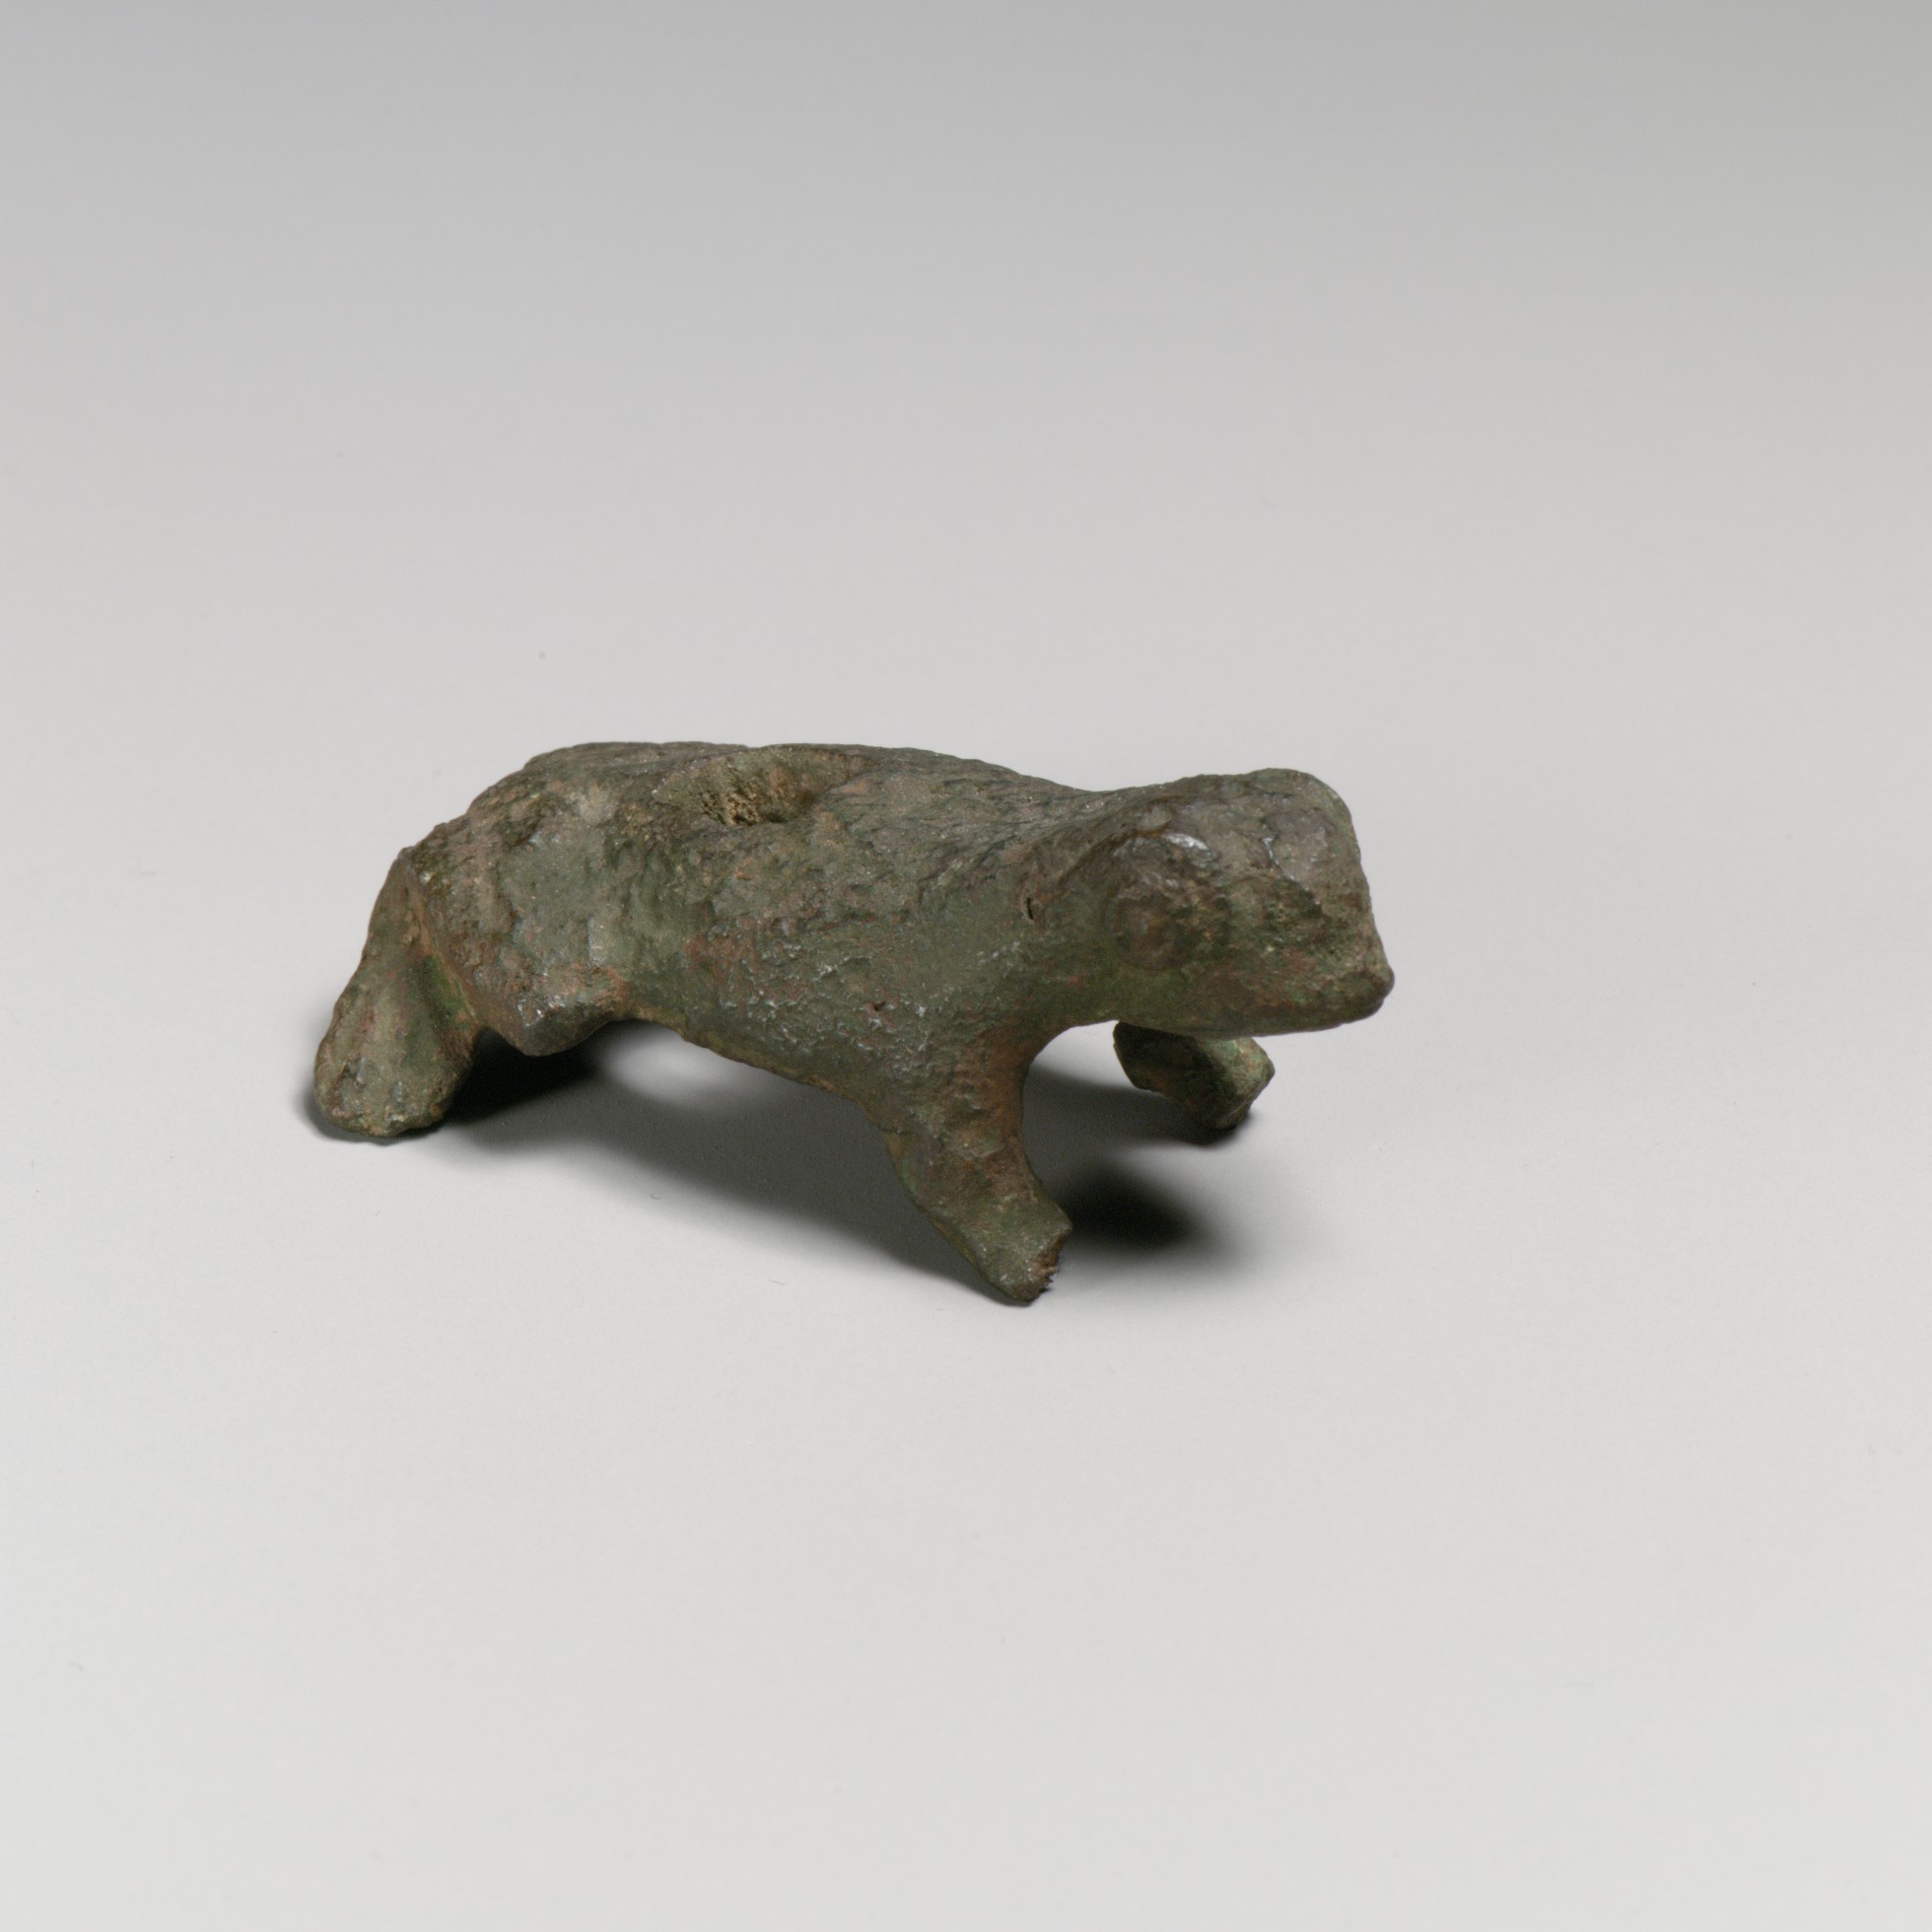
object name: statuette of a frog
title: Bronze frog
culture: etruscan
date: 575-550 BCE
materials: bronze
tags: frogs